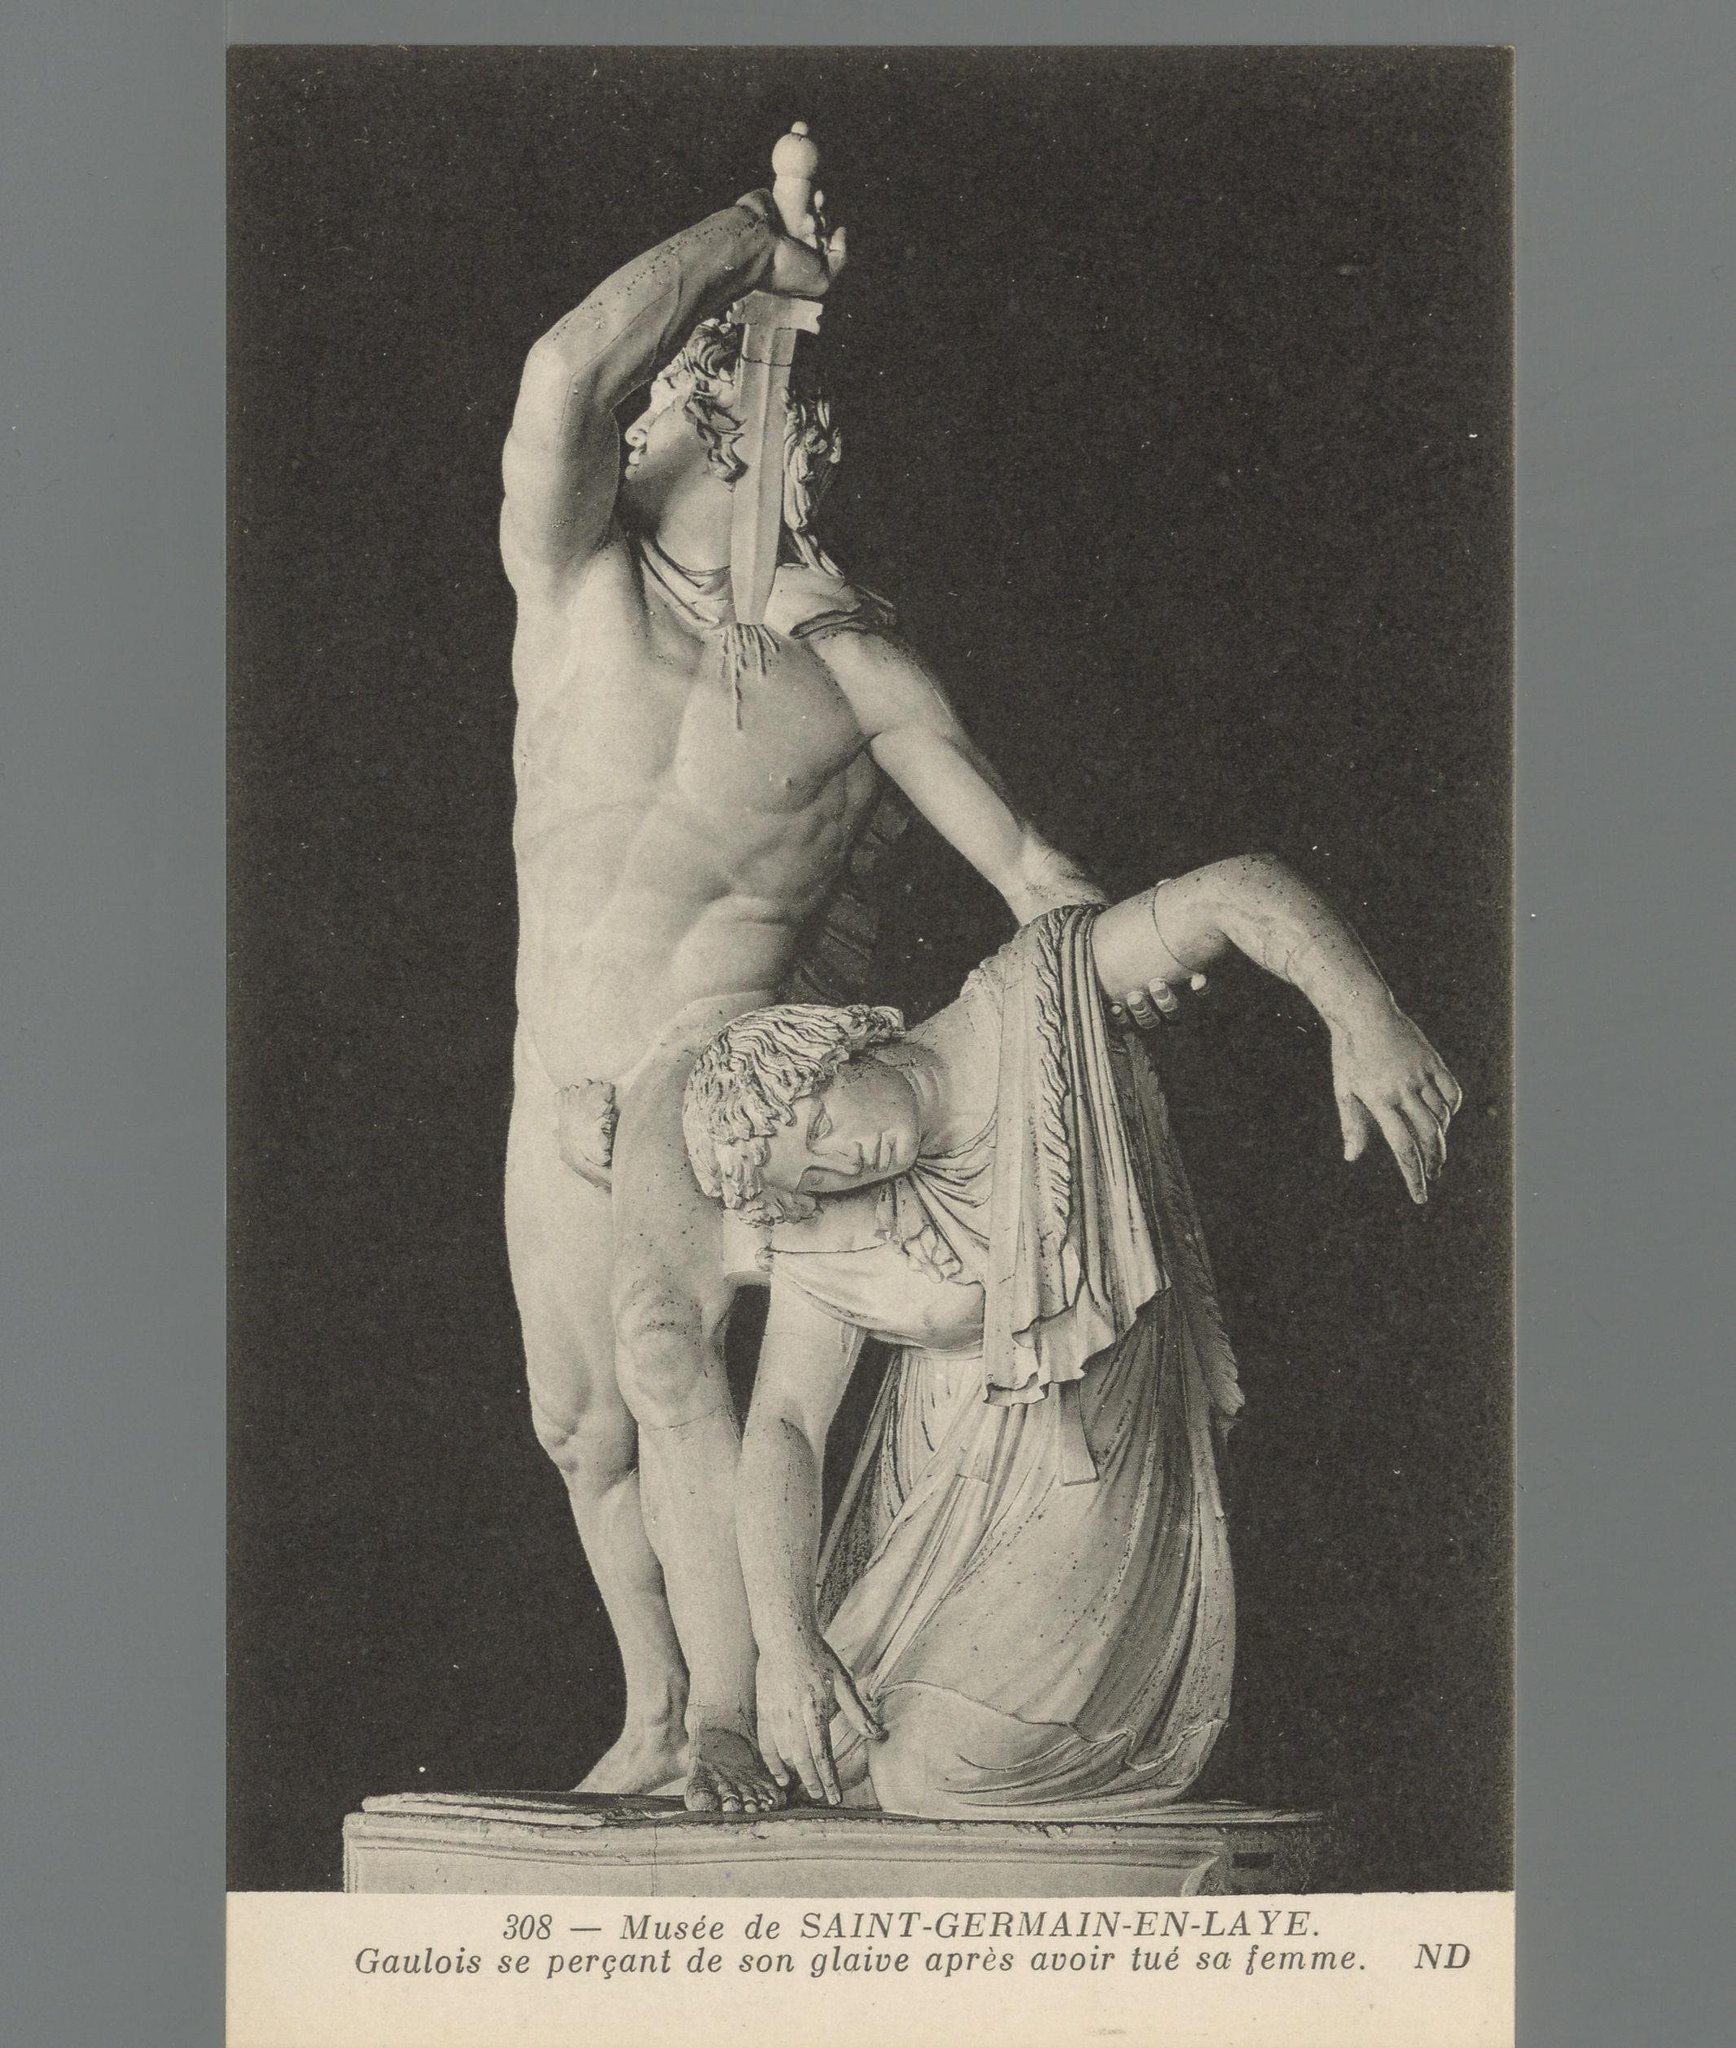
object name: photomechanical print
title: Musée de Saint-Germain-en-Laye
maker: Anonymous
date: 1903-1918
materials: cardboard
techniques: photograph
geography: saint-germain-en-laye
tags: monument, statue, permanent exhibition, museum